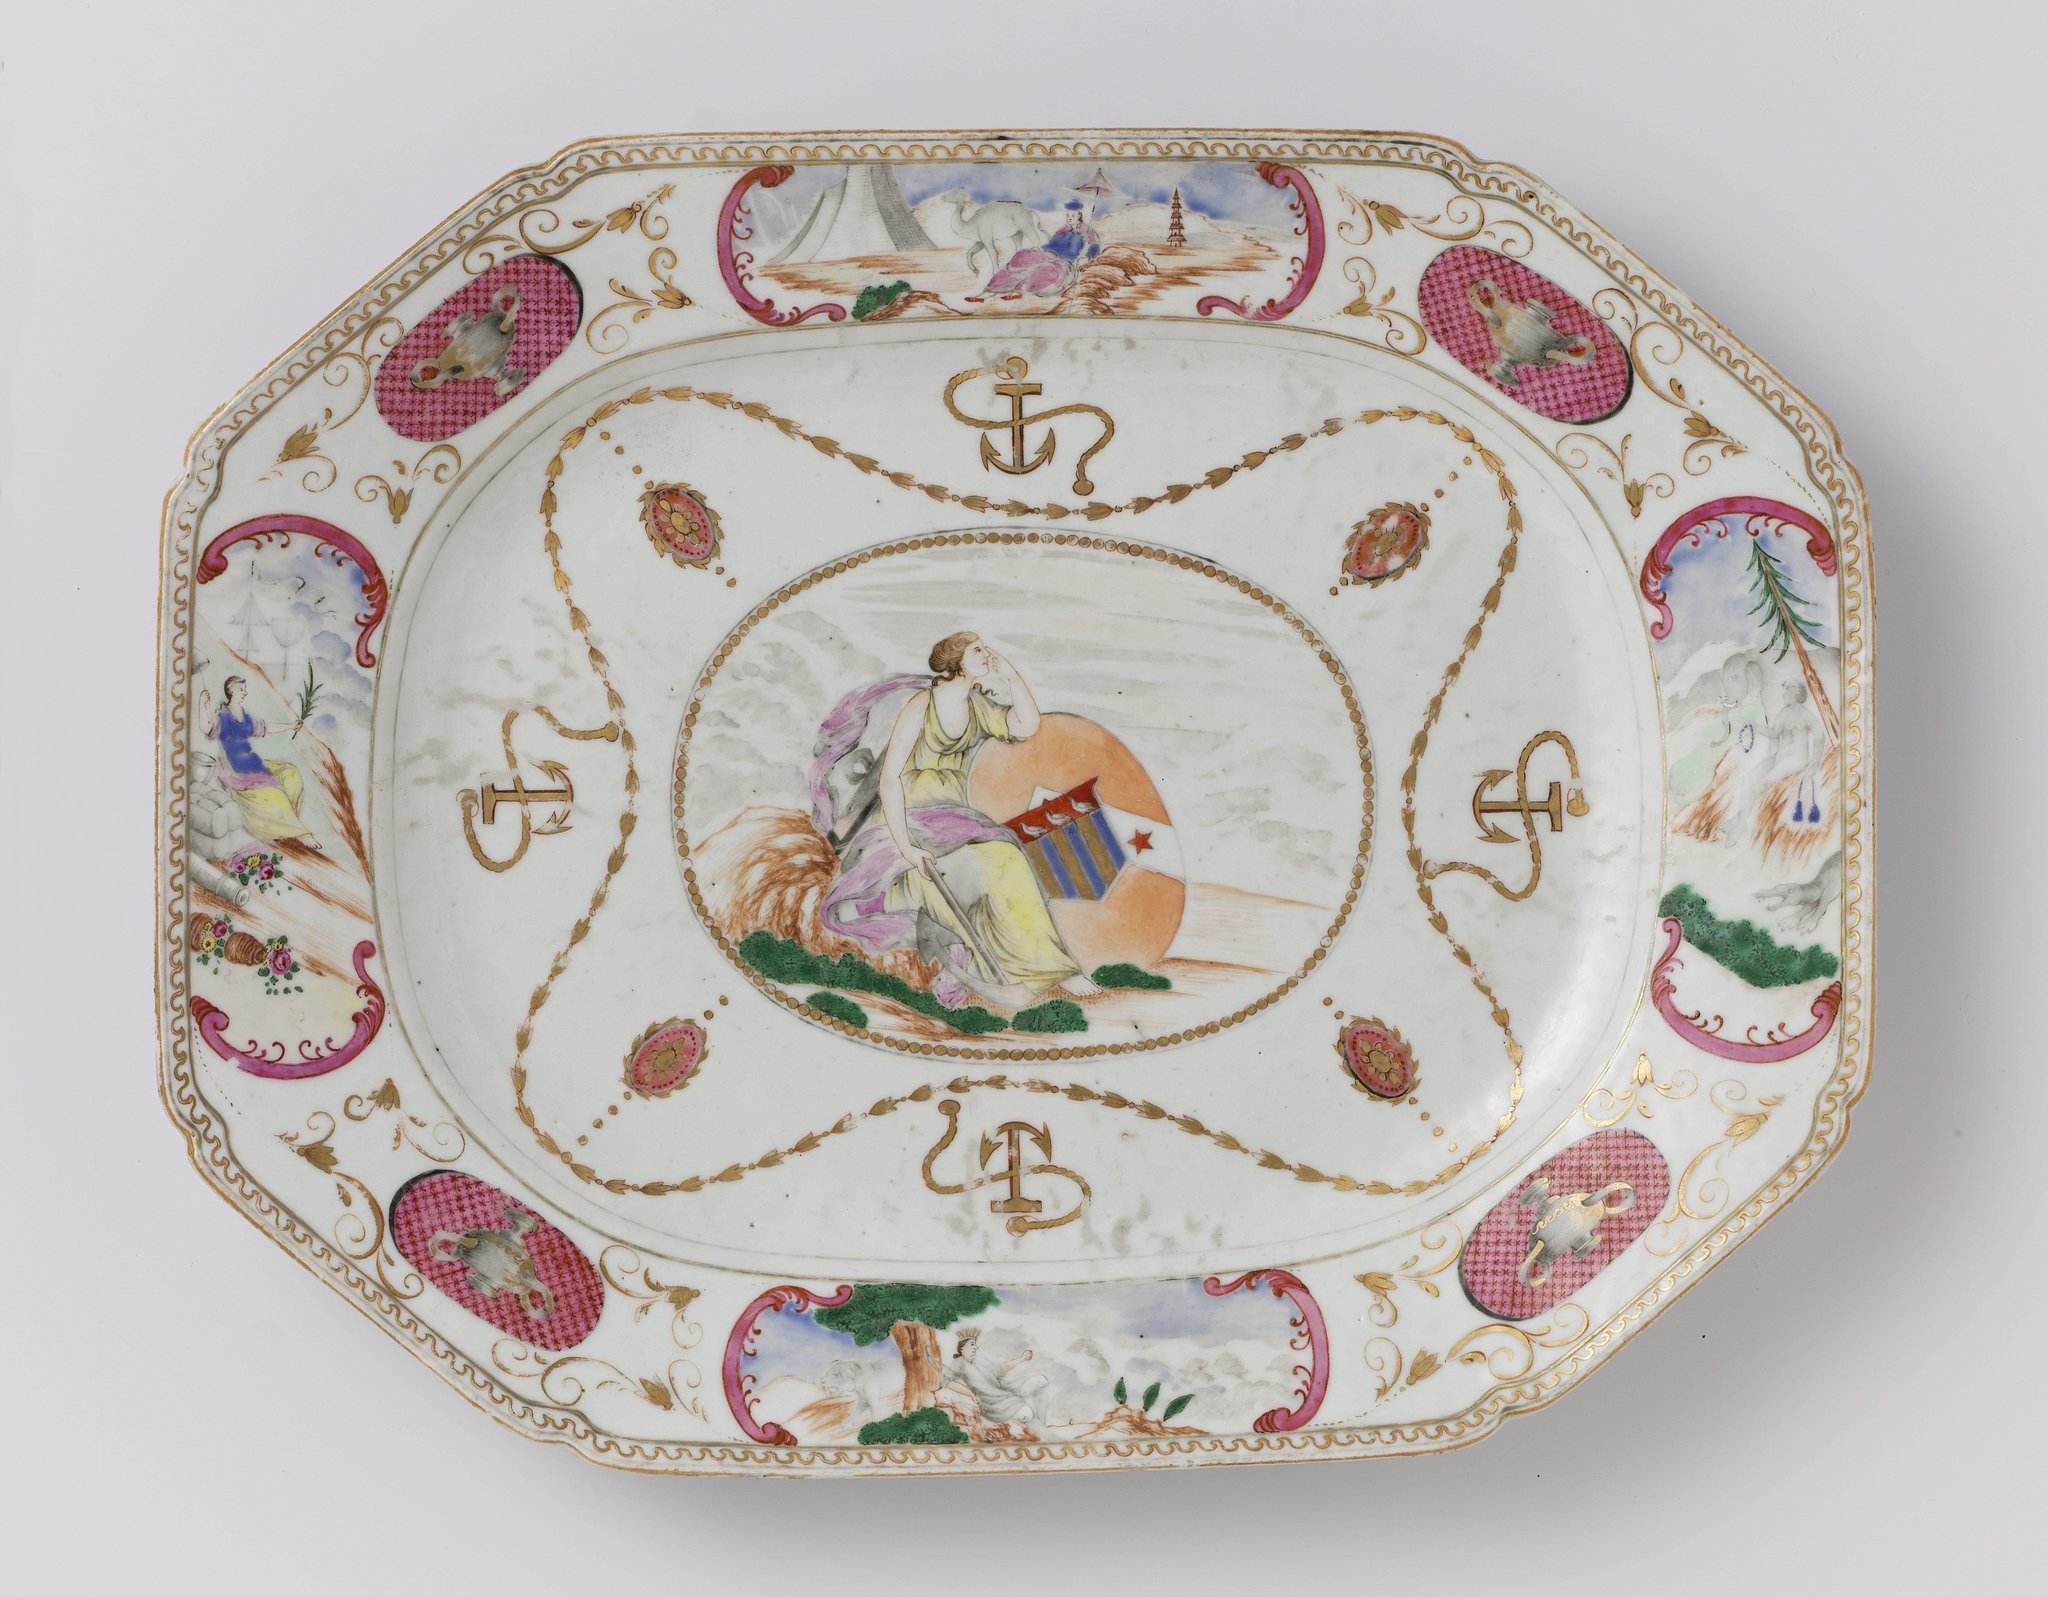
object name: platter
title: Octagonal, rectangular dish with the arms of the Ker and Martin family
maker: Anonymous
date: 1775-1799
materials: glaze, gold, paint, porcelain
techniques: firing, forming, gilding, turning, vitrification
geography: china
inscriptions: inscription: ‘Arms of/ William Ker born 1775/ of Gats[...]-Rex[...]/ who married his cousin [...]/ [...] of Ellis Martin/ by his first wife Elisabeth Ker [?]’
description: Langwerpige, achthoekige schotel van porselein met ingeknepen hoeken, beschilderd op het glazuur in blauw, rood, roze, groen, geel, bruin, zwart en goud. Op het plat een medaillon met een klassiek geklede vrouw met een anker, de allegorie van de hoop, zittend op een rots en leunend op het wapen van de familie Ker met als hartschild het wapen van de familie Martin. Om het medaillon een golvende band met medaillons en ankers. Op de rand vier cartouches met allegorische voorstellingen van de vier werelddelen; daartussen ranken en medaillons met een urn. Enkele chips in de rand. Wapenporselein met emailkleuren.